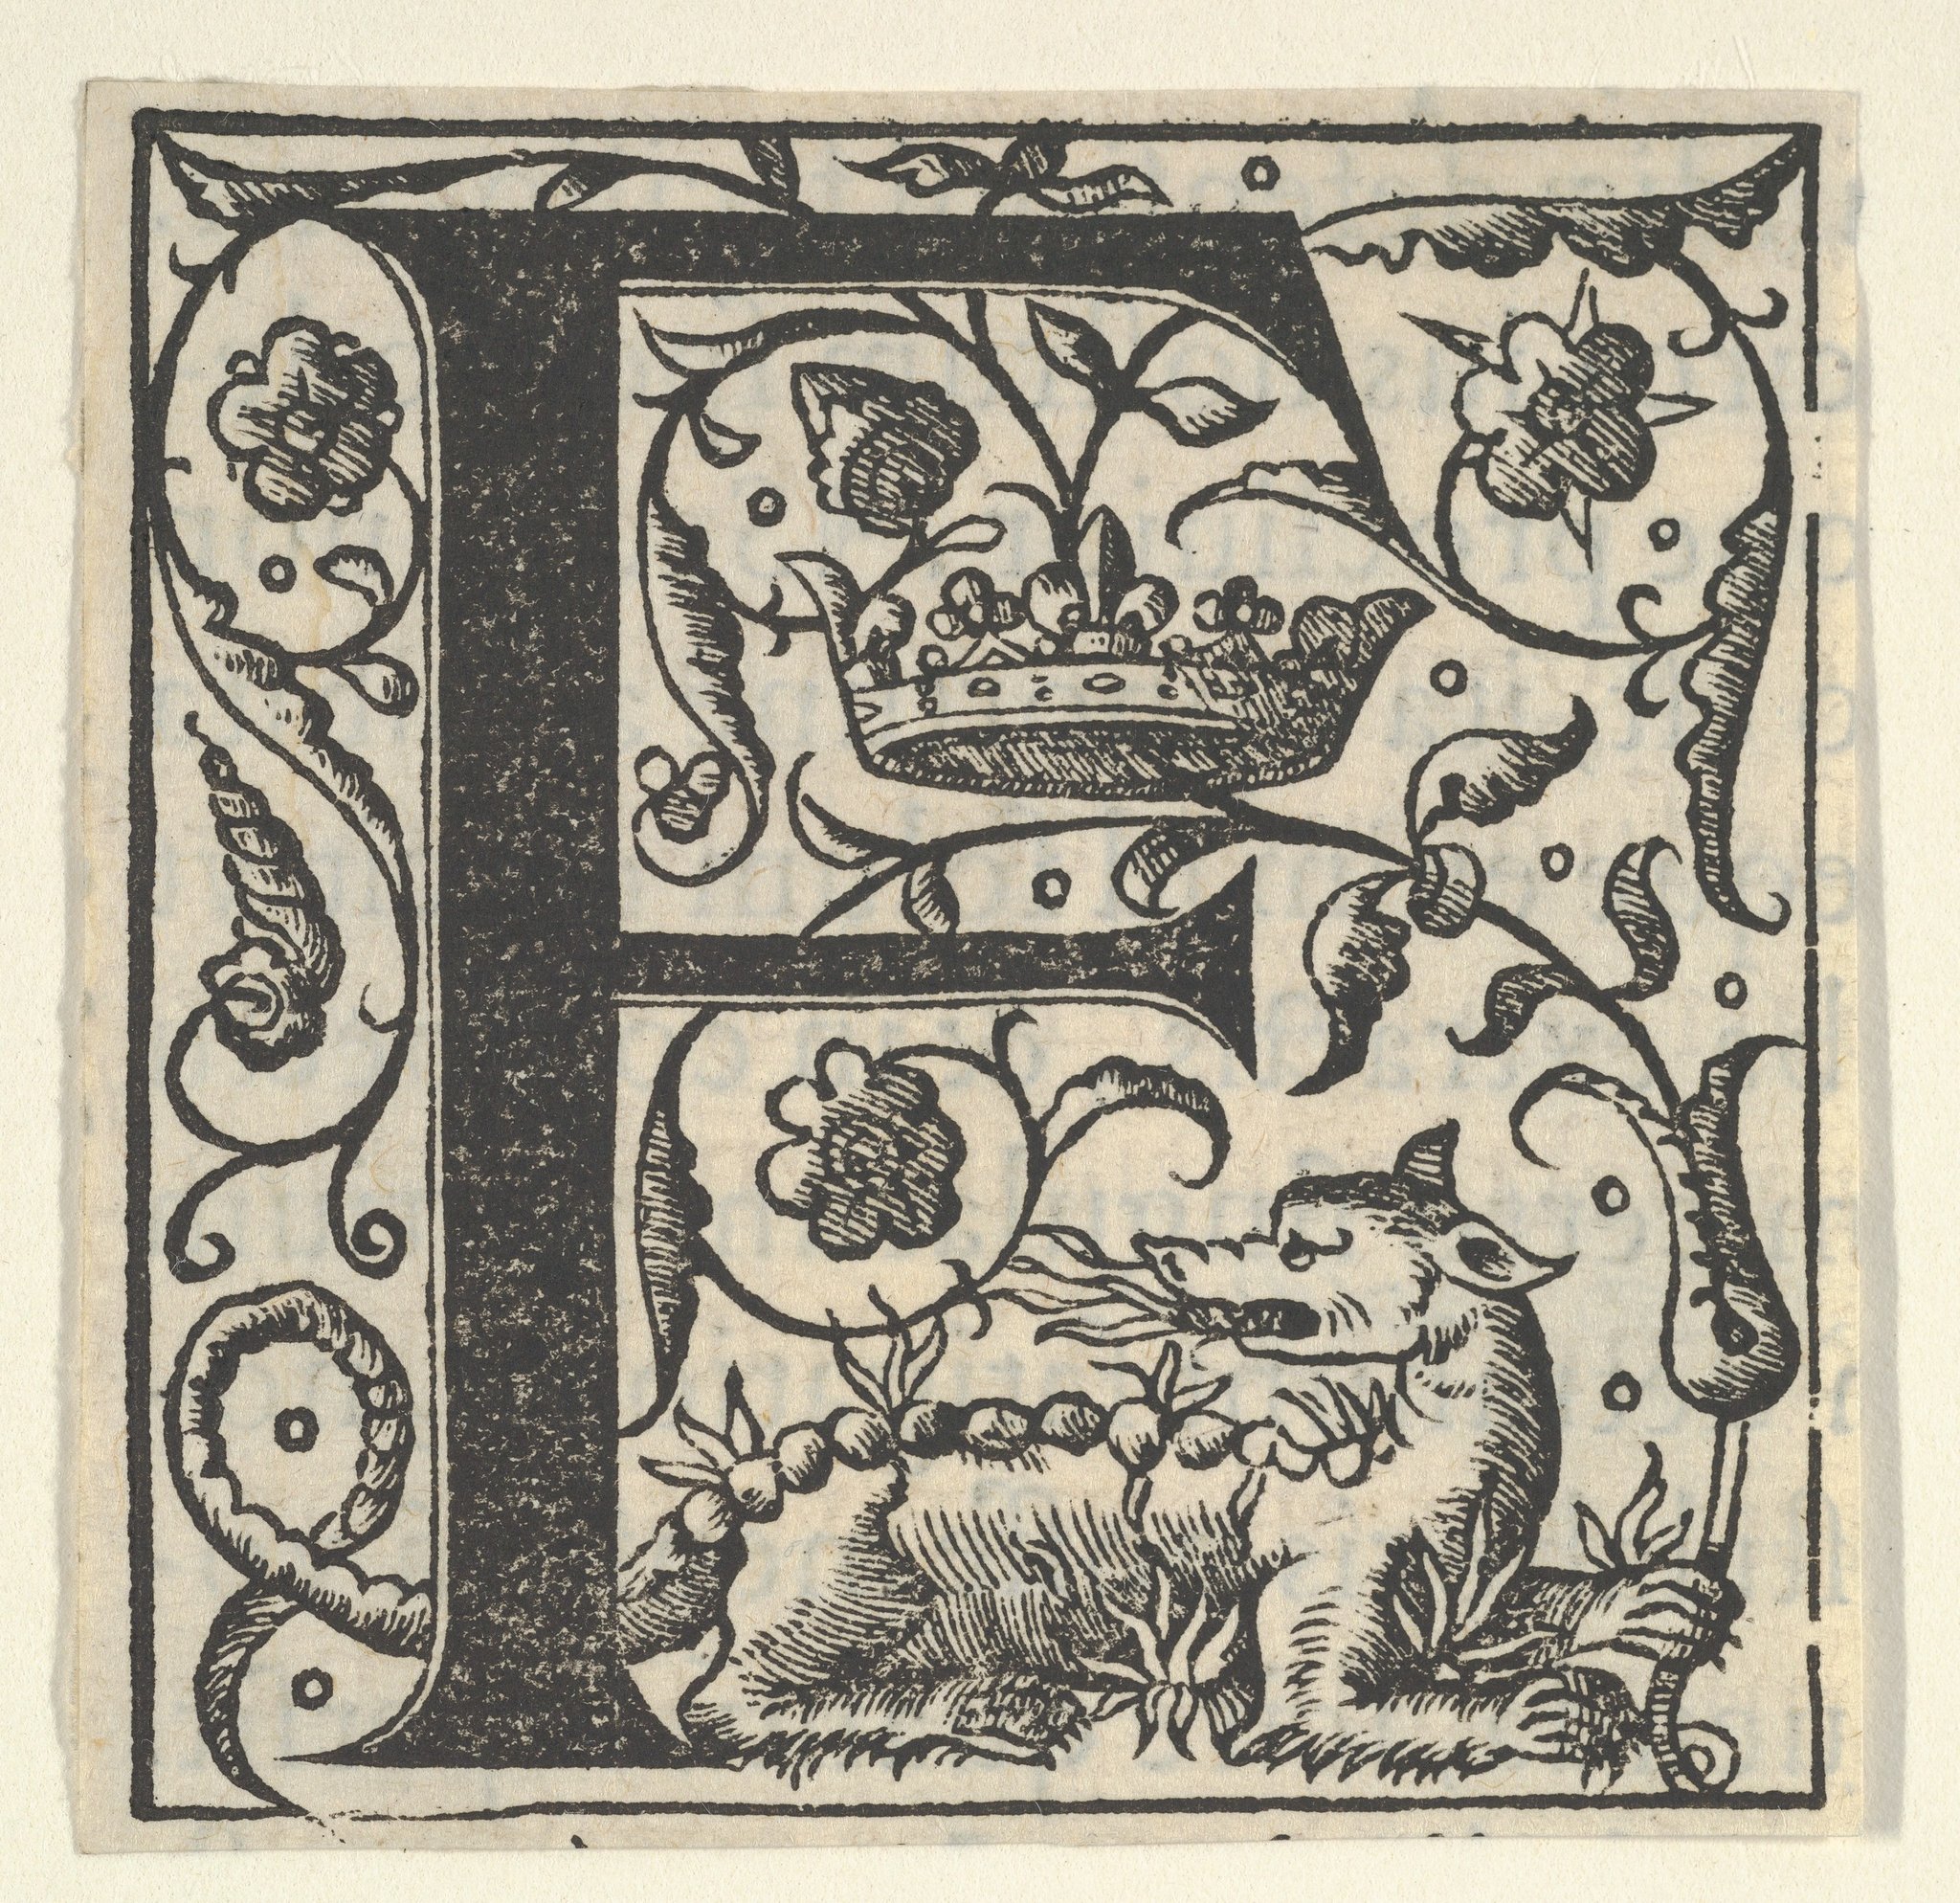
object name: print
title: Initial letter F with salamander and crown (related to King Francis I)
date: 1534-1566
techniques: woodcut